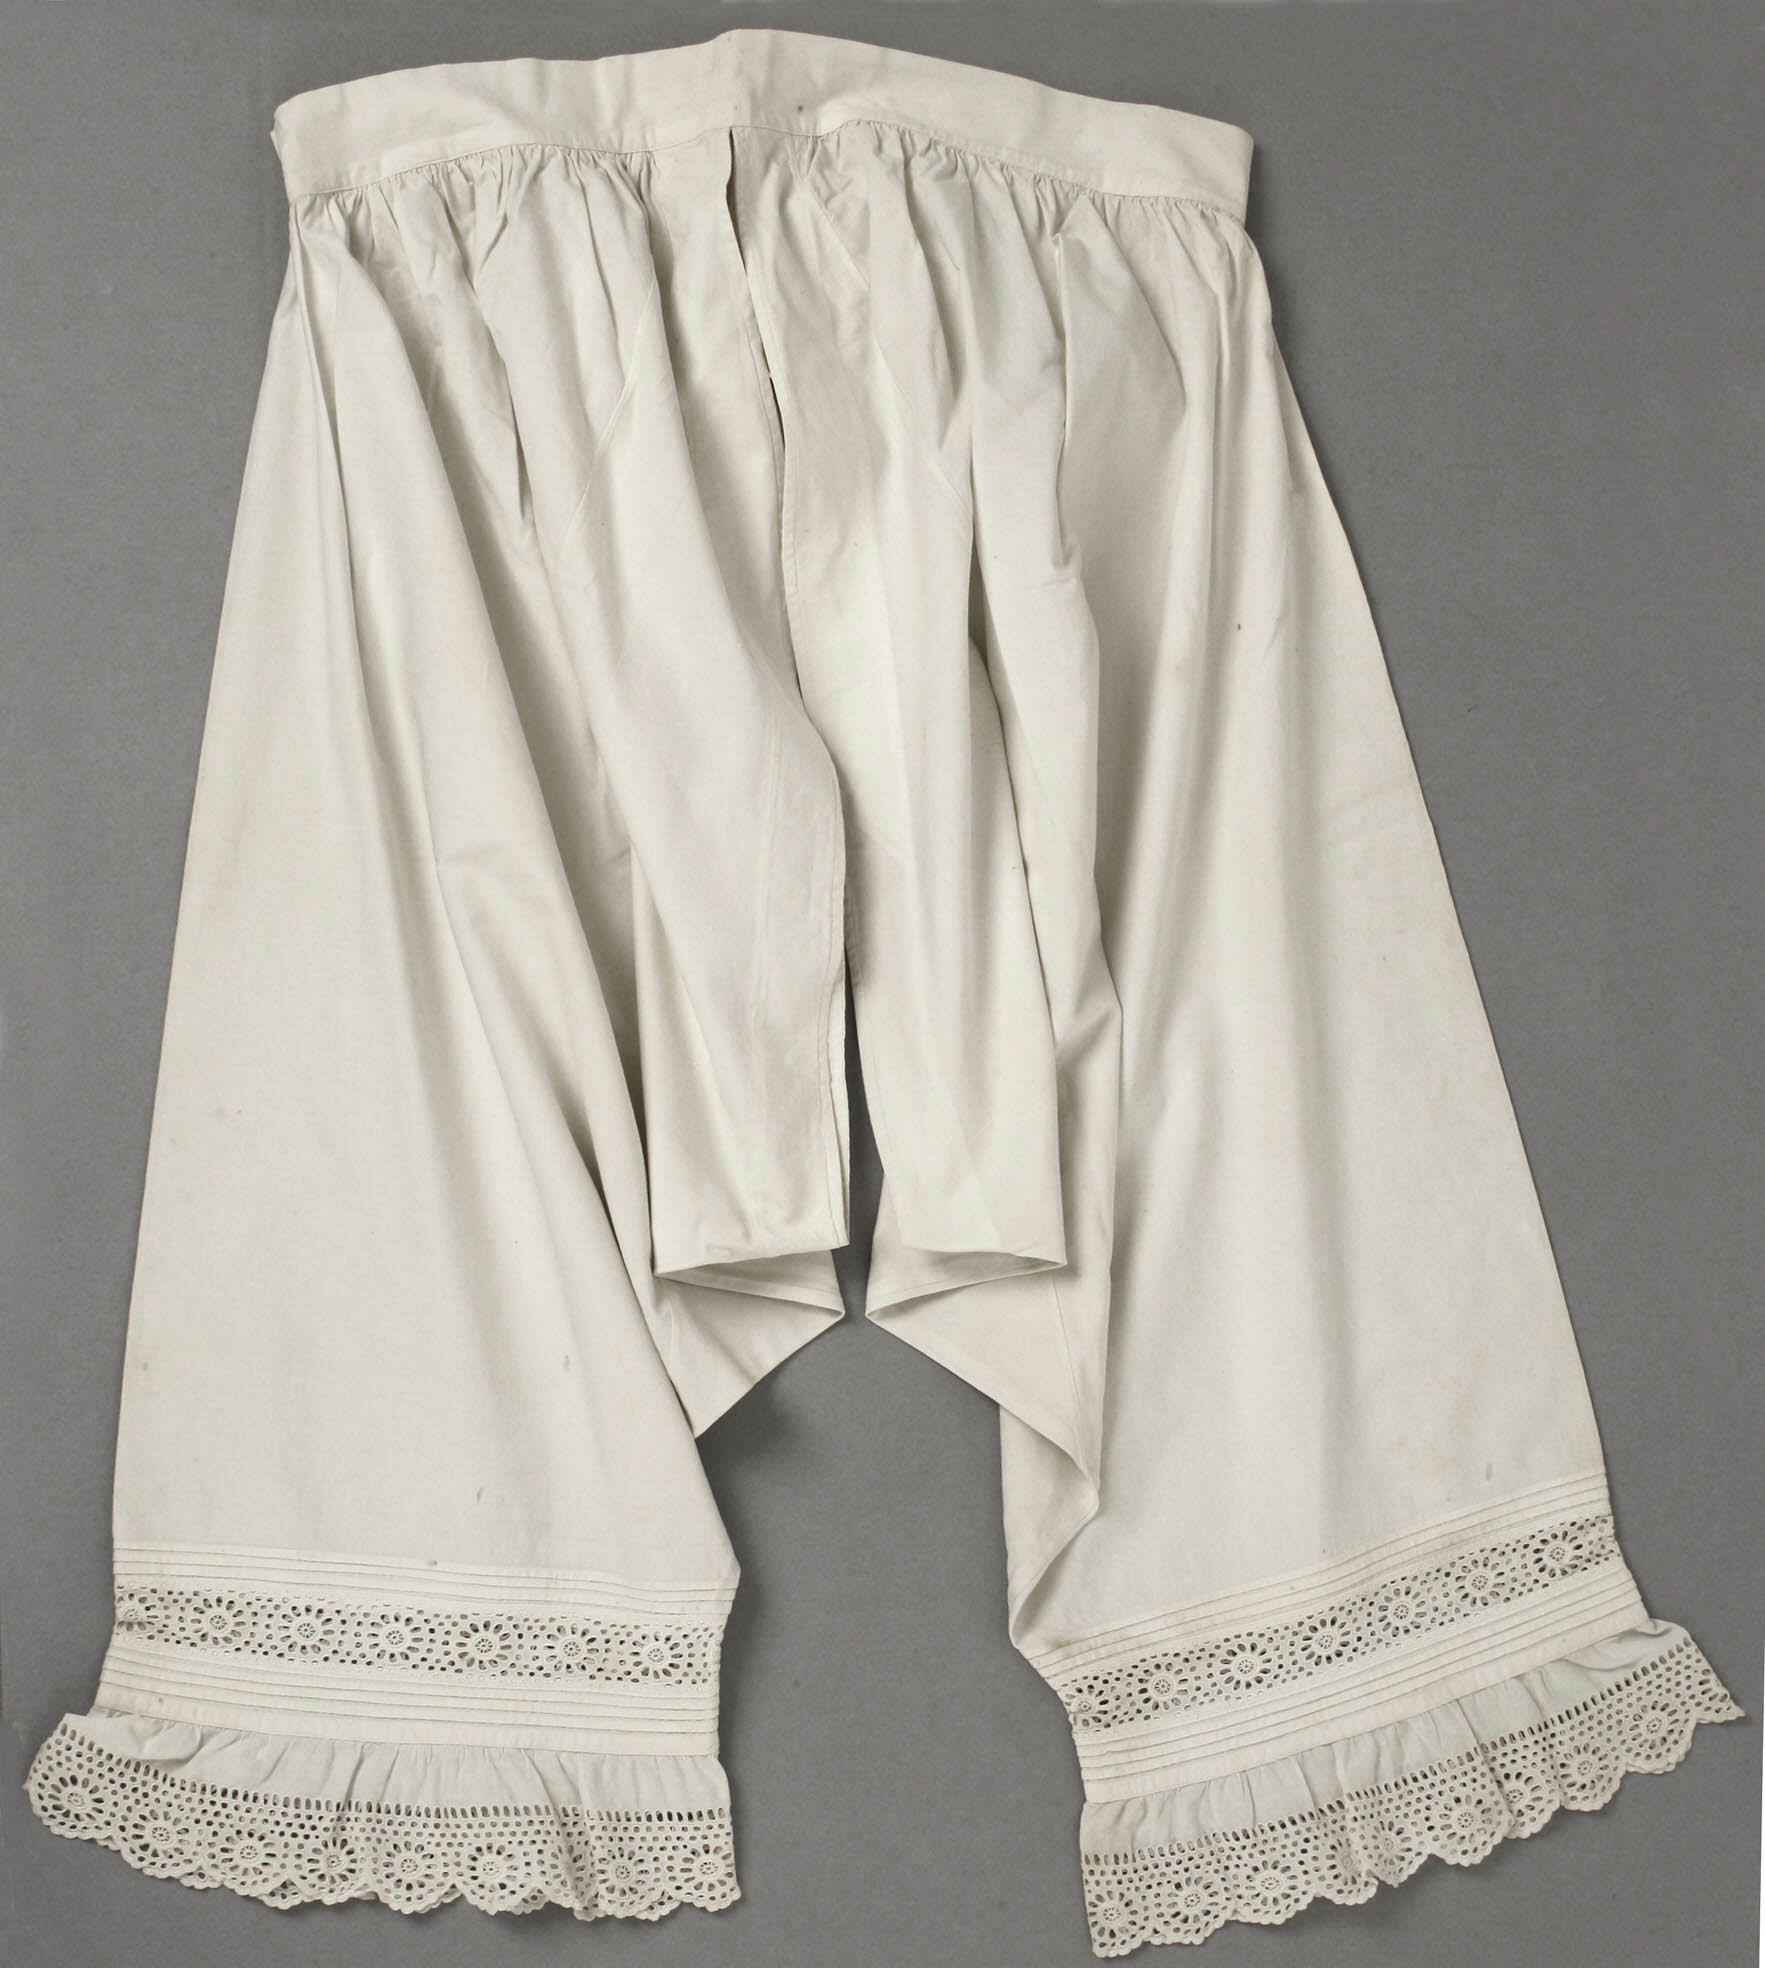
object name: drawer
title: Drawers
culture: american or european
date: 1860-1869